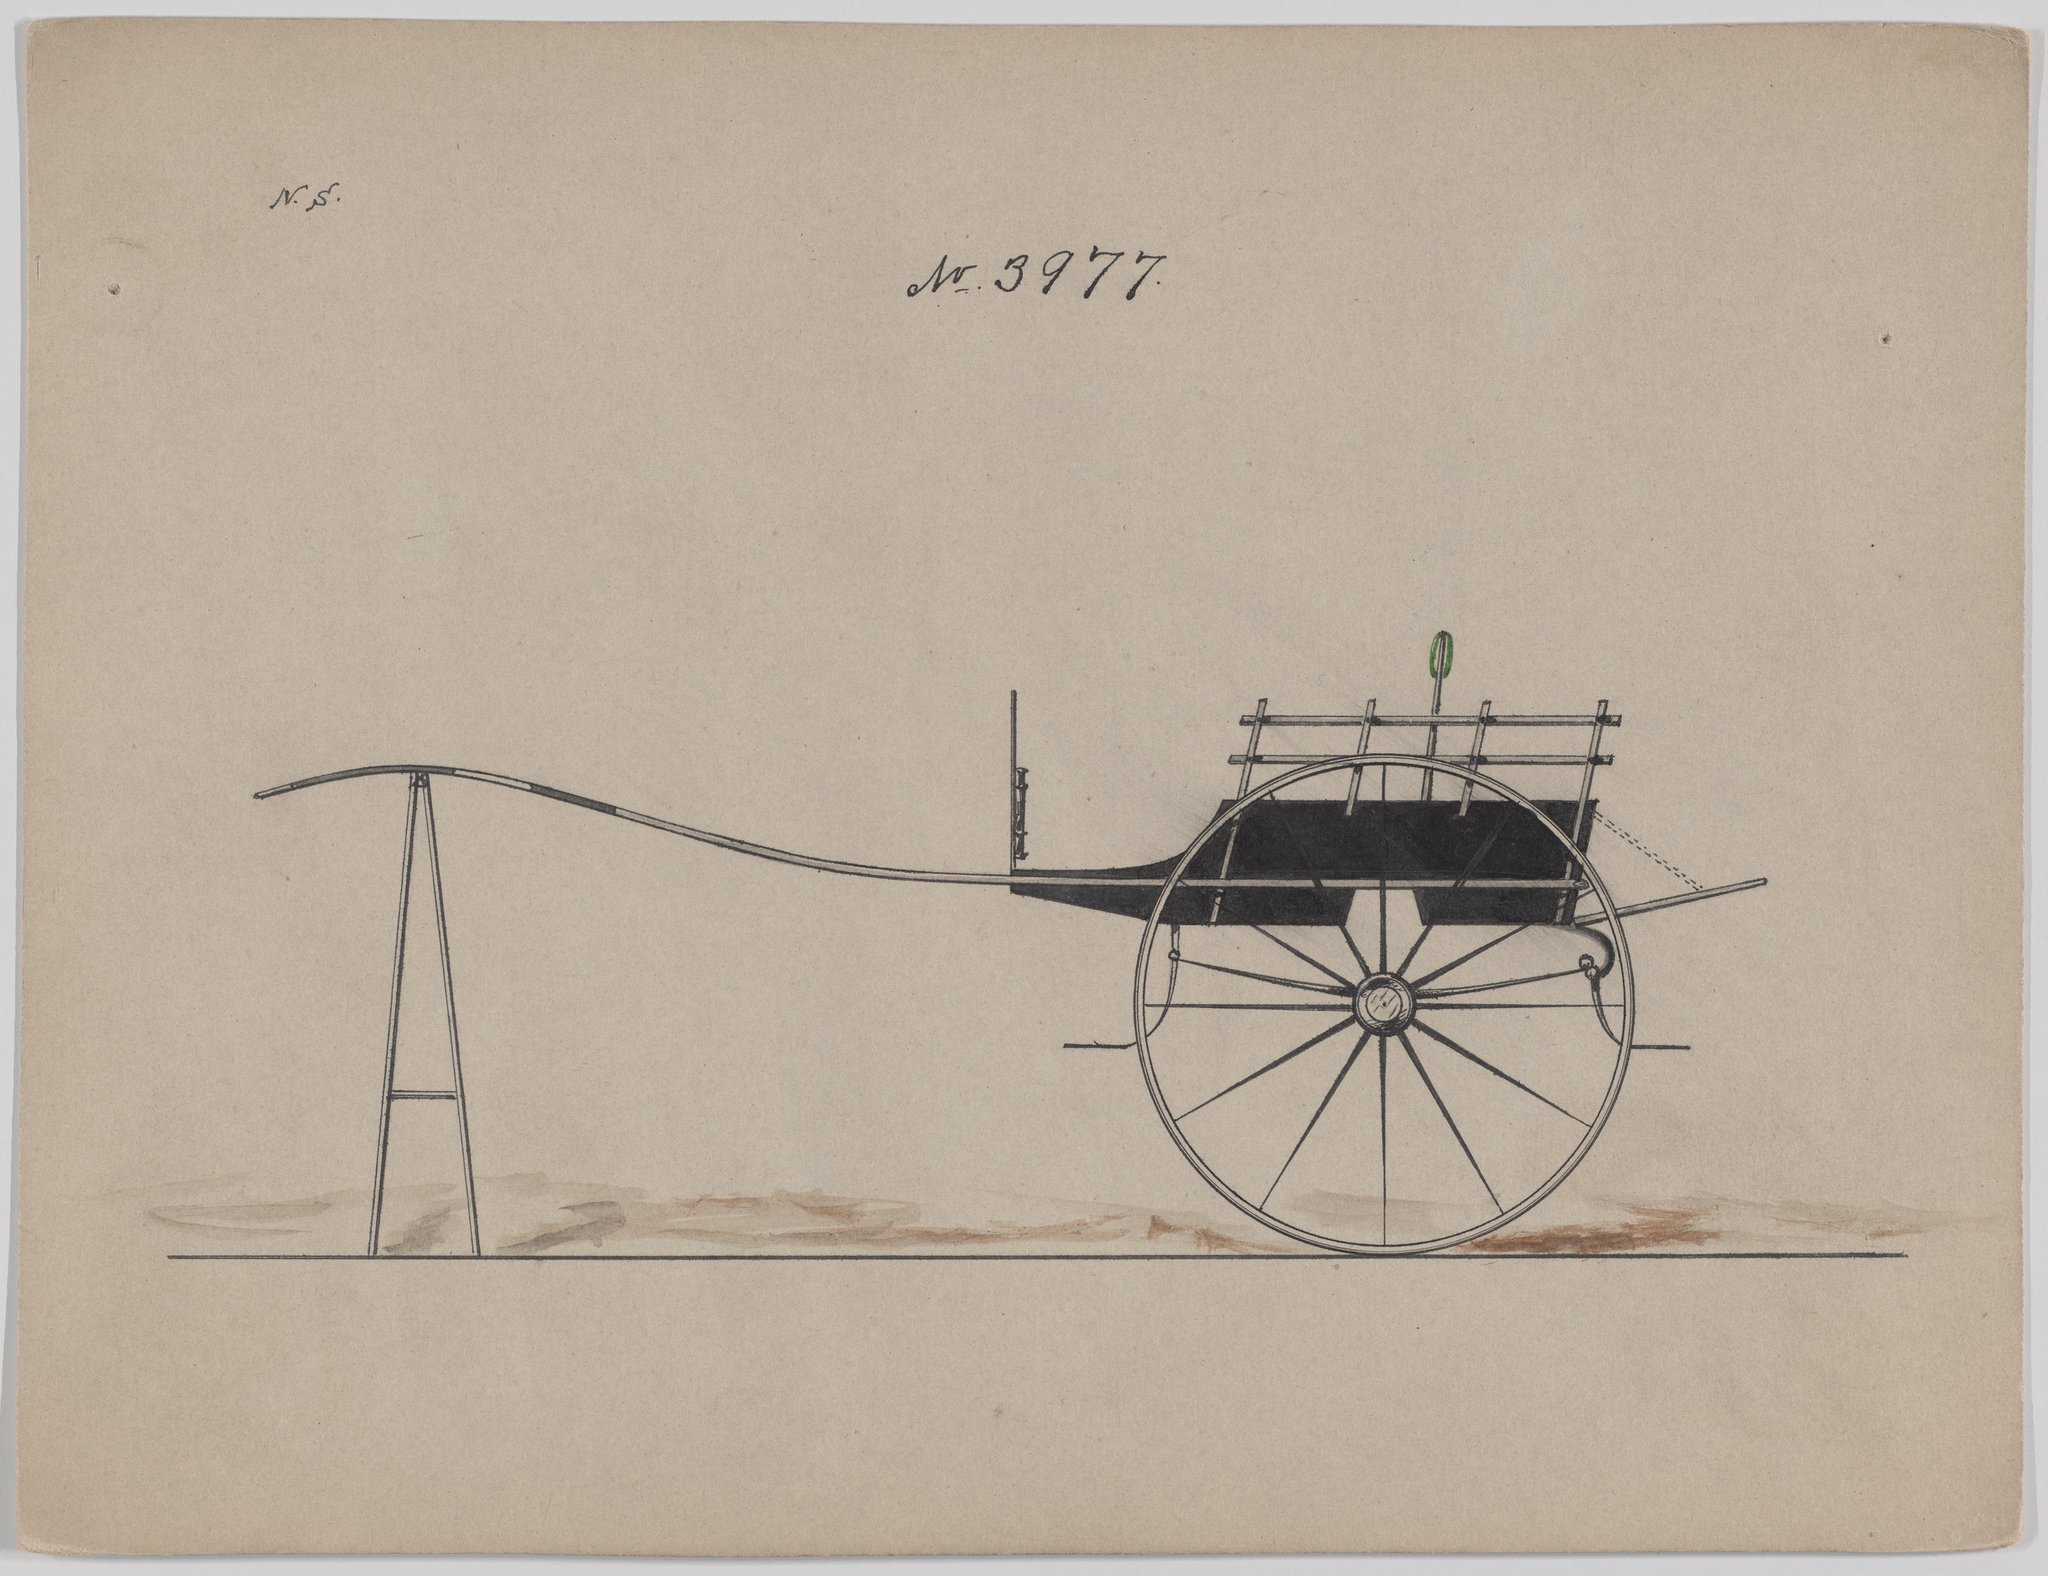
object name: drawing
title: Design for Dog Cart or 2 Wheeler, no. 3977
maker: brewster & co.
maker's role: manufacturer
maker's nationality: american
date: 1886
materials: ink, watercolor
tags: carriages